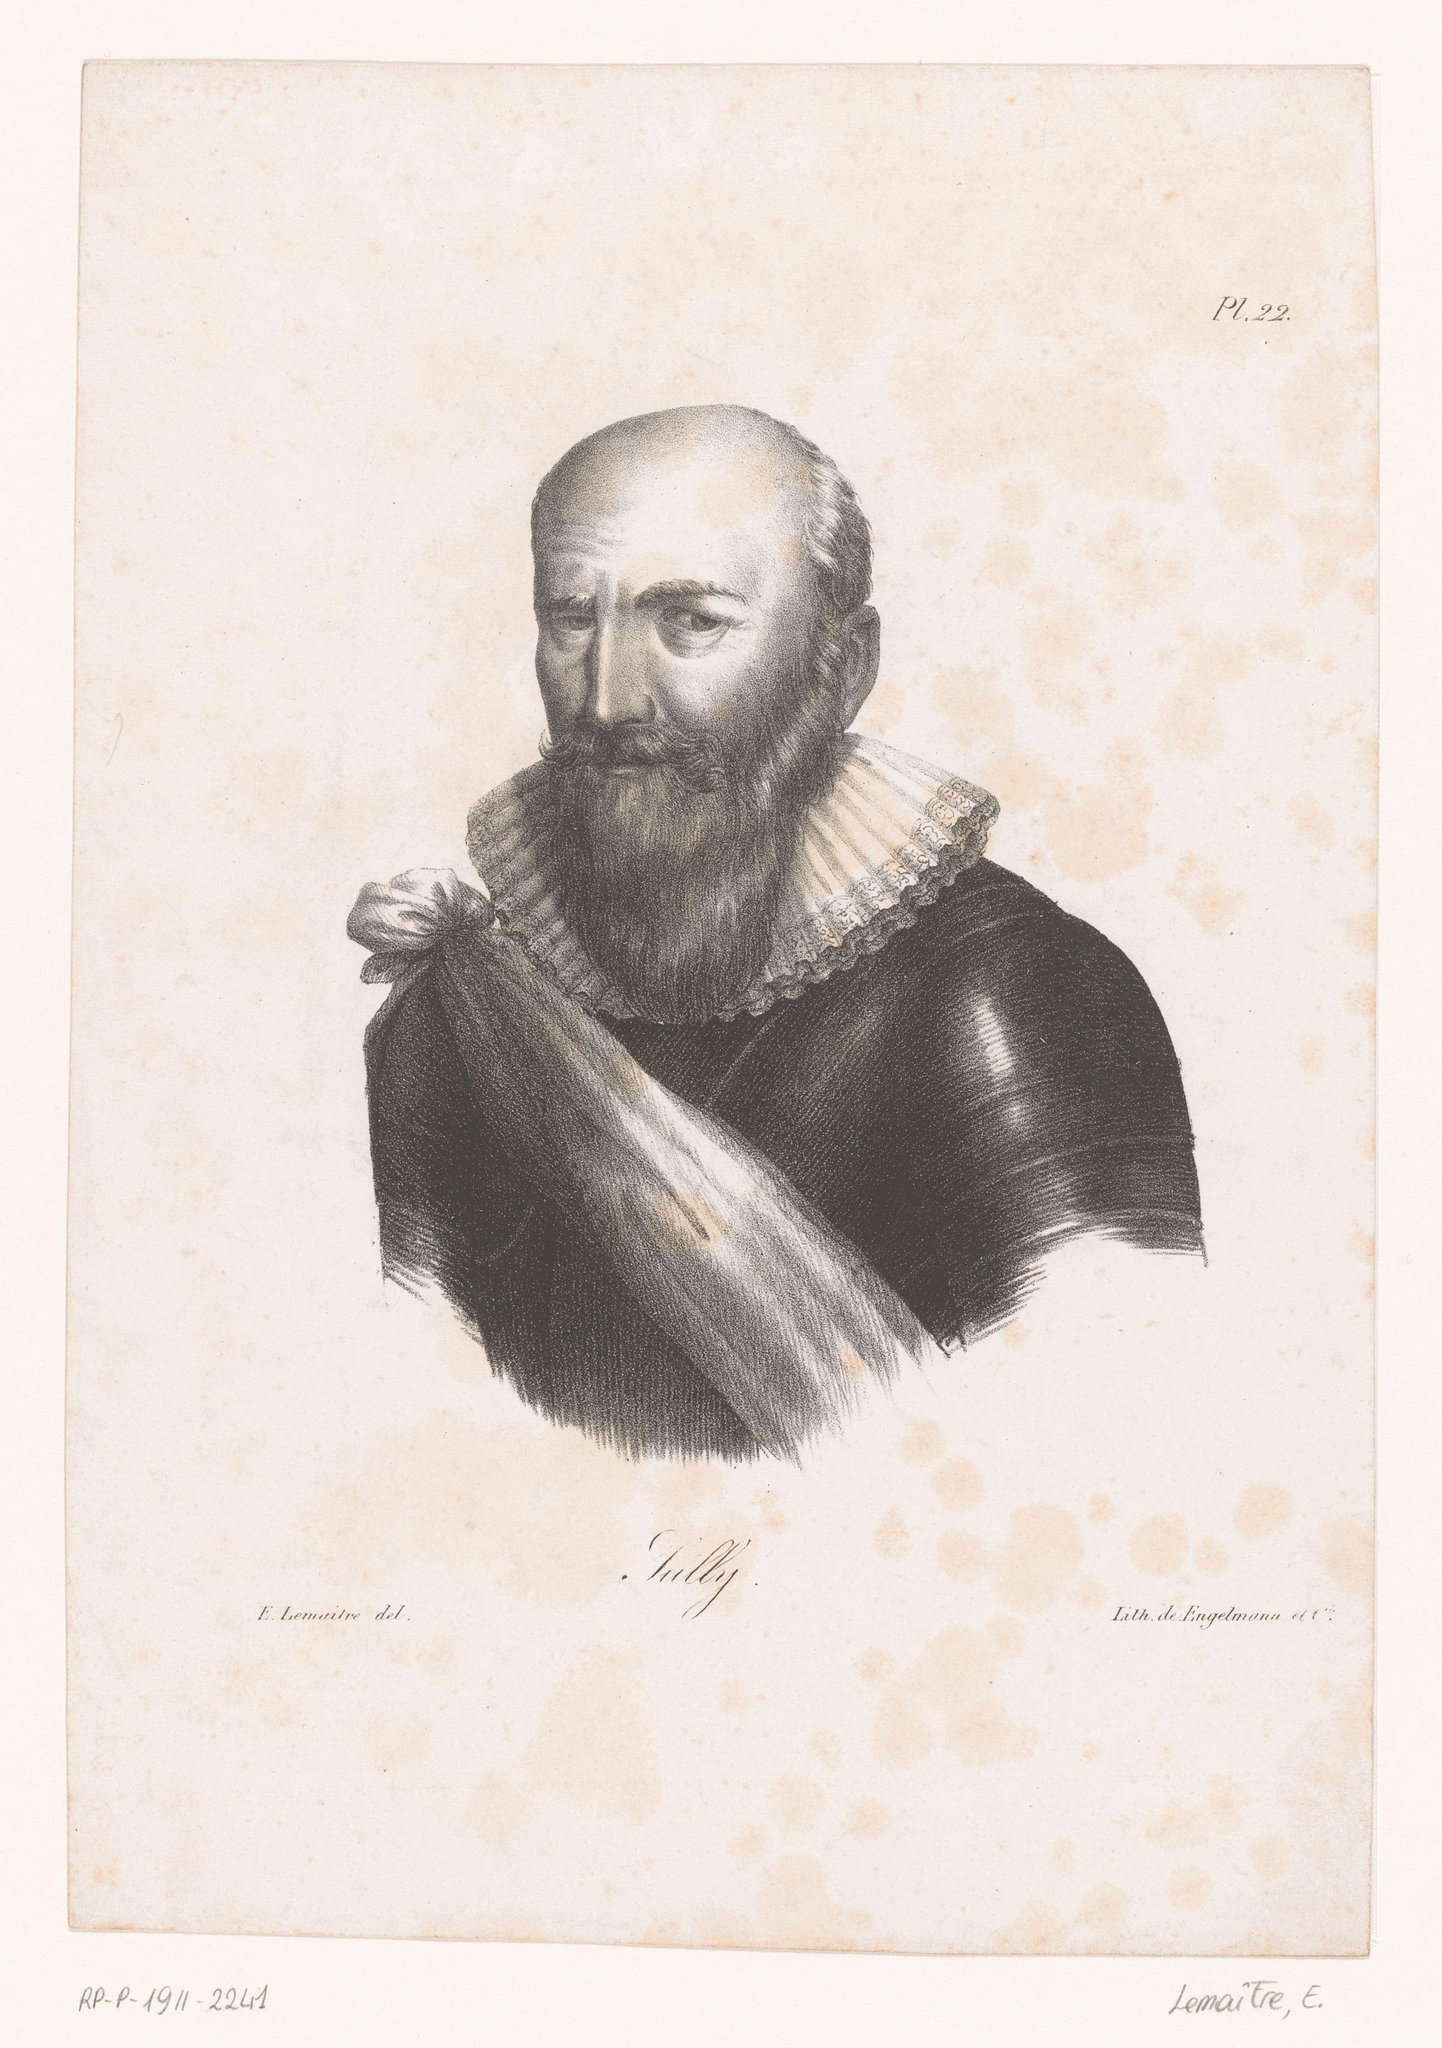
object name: print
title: Portret van Maximilien de Béthune, hertog van Sully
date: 1855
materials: paper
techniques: lithograph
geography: paris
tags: maximilien de béthune (duke of sully), historical persons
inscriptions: collector's mark: Lugt 2228a